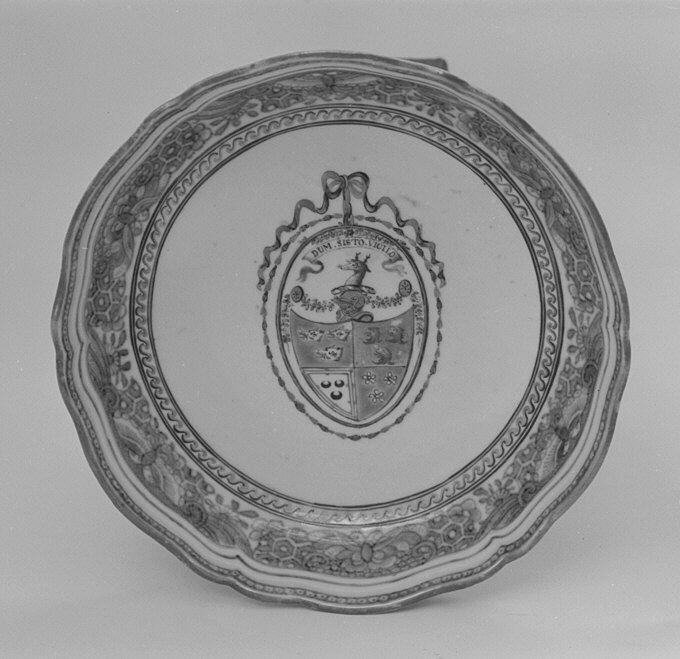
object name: saucer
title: Saucer (part of a service)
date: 1770-1785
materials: hard paste porcelain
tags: coat of arms